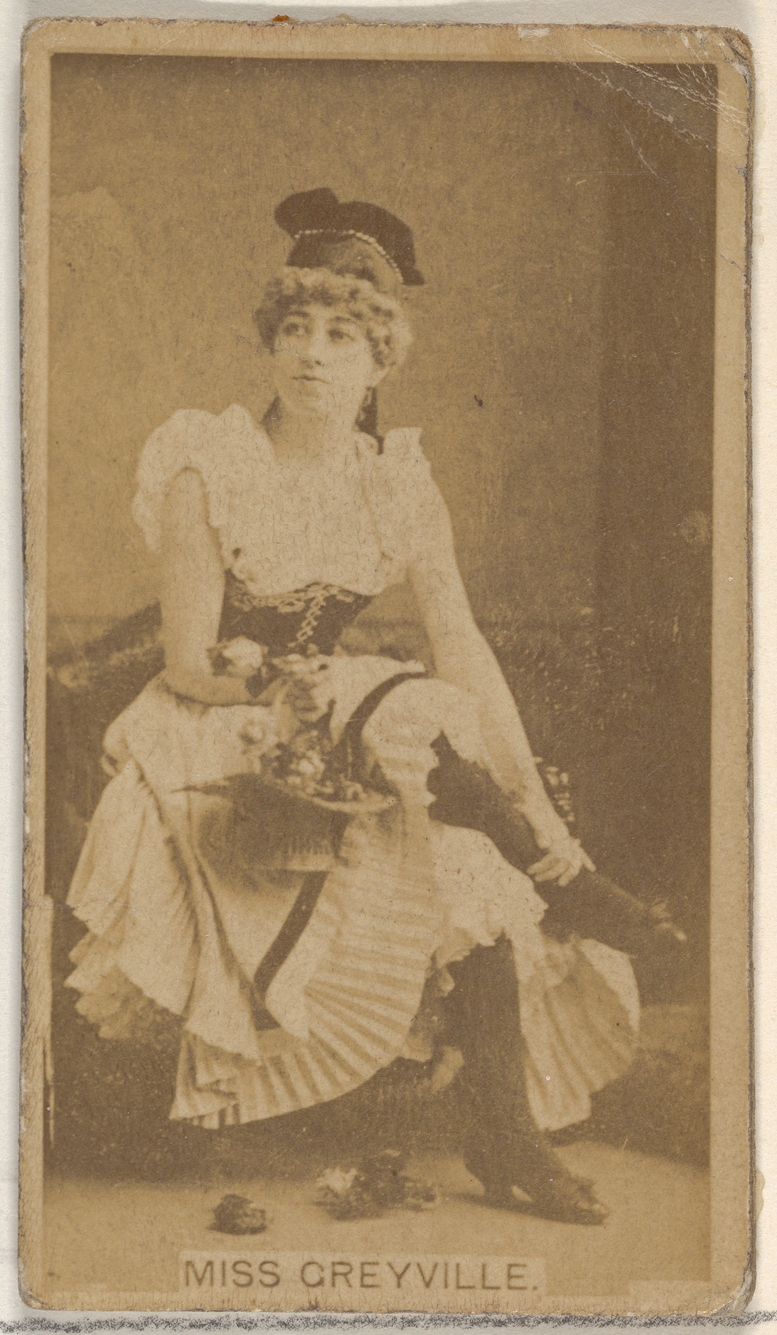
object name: photograph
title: Miss Greyville, from the Actors and Actresses series (N45, Type 8) for Virginia Brights Cigarettes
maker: allen & ginter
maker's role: publisher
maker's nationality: american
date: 1888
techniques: albumen silver print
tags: portraits,women,actresses